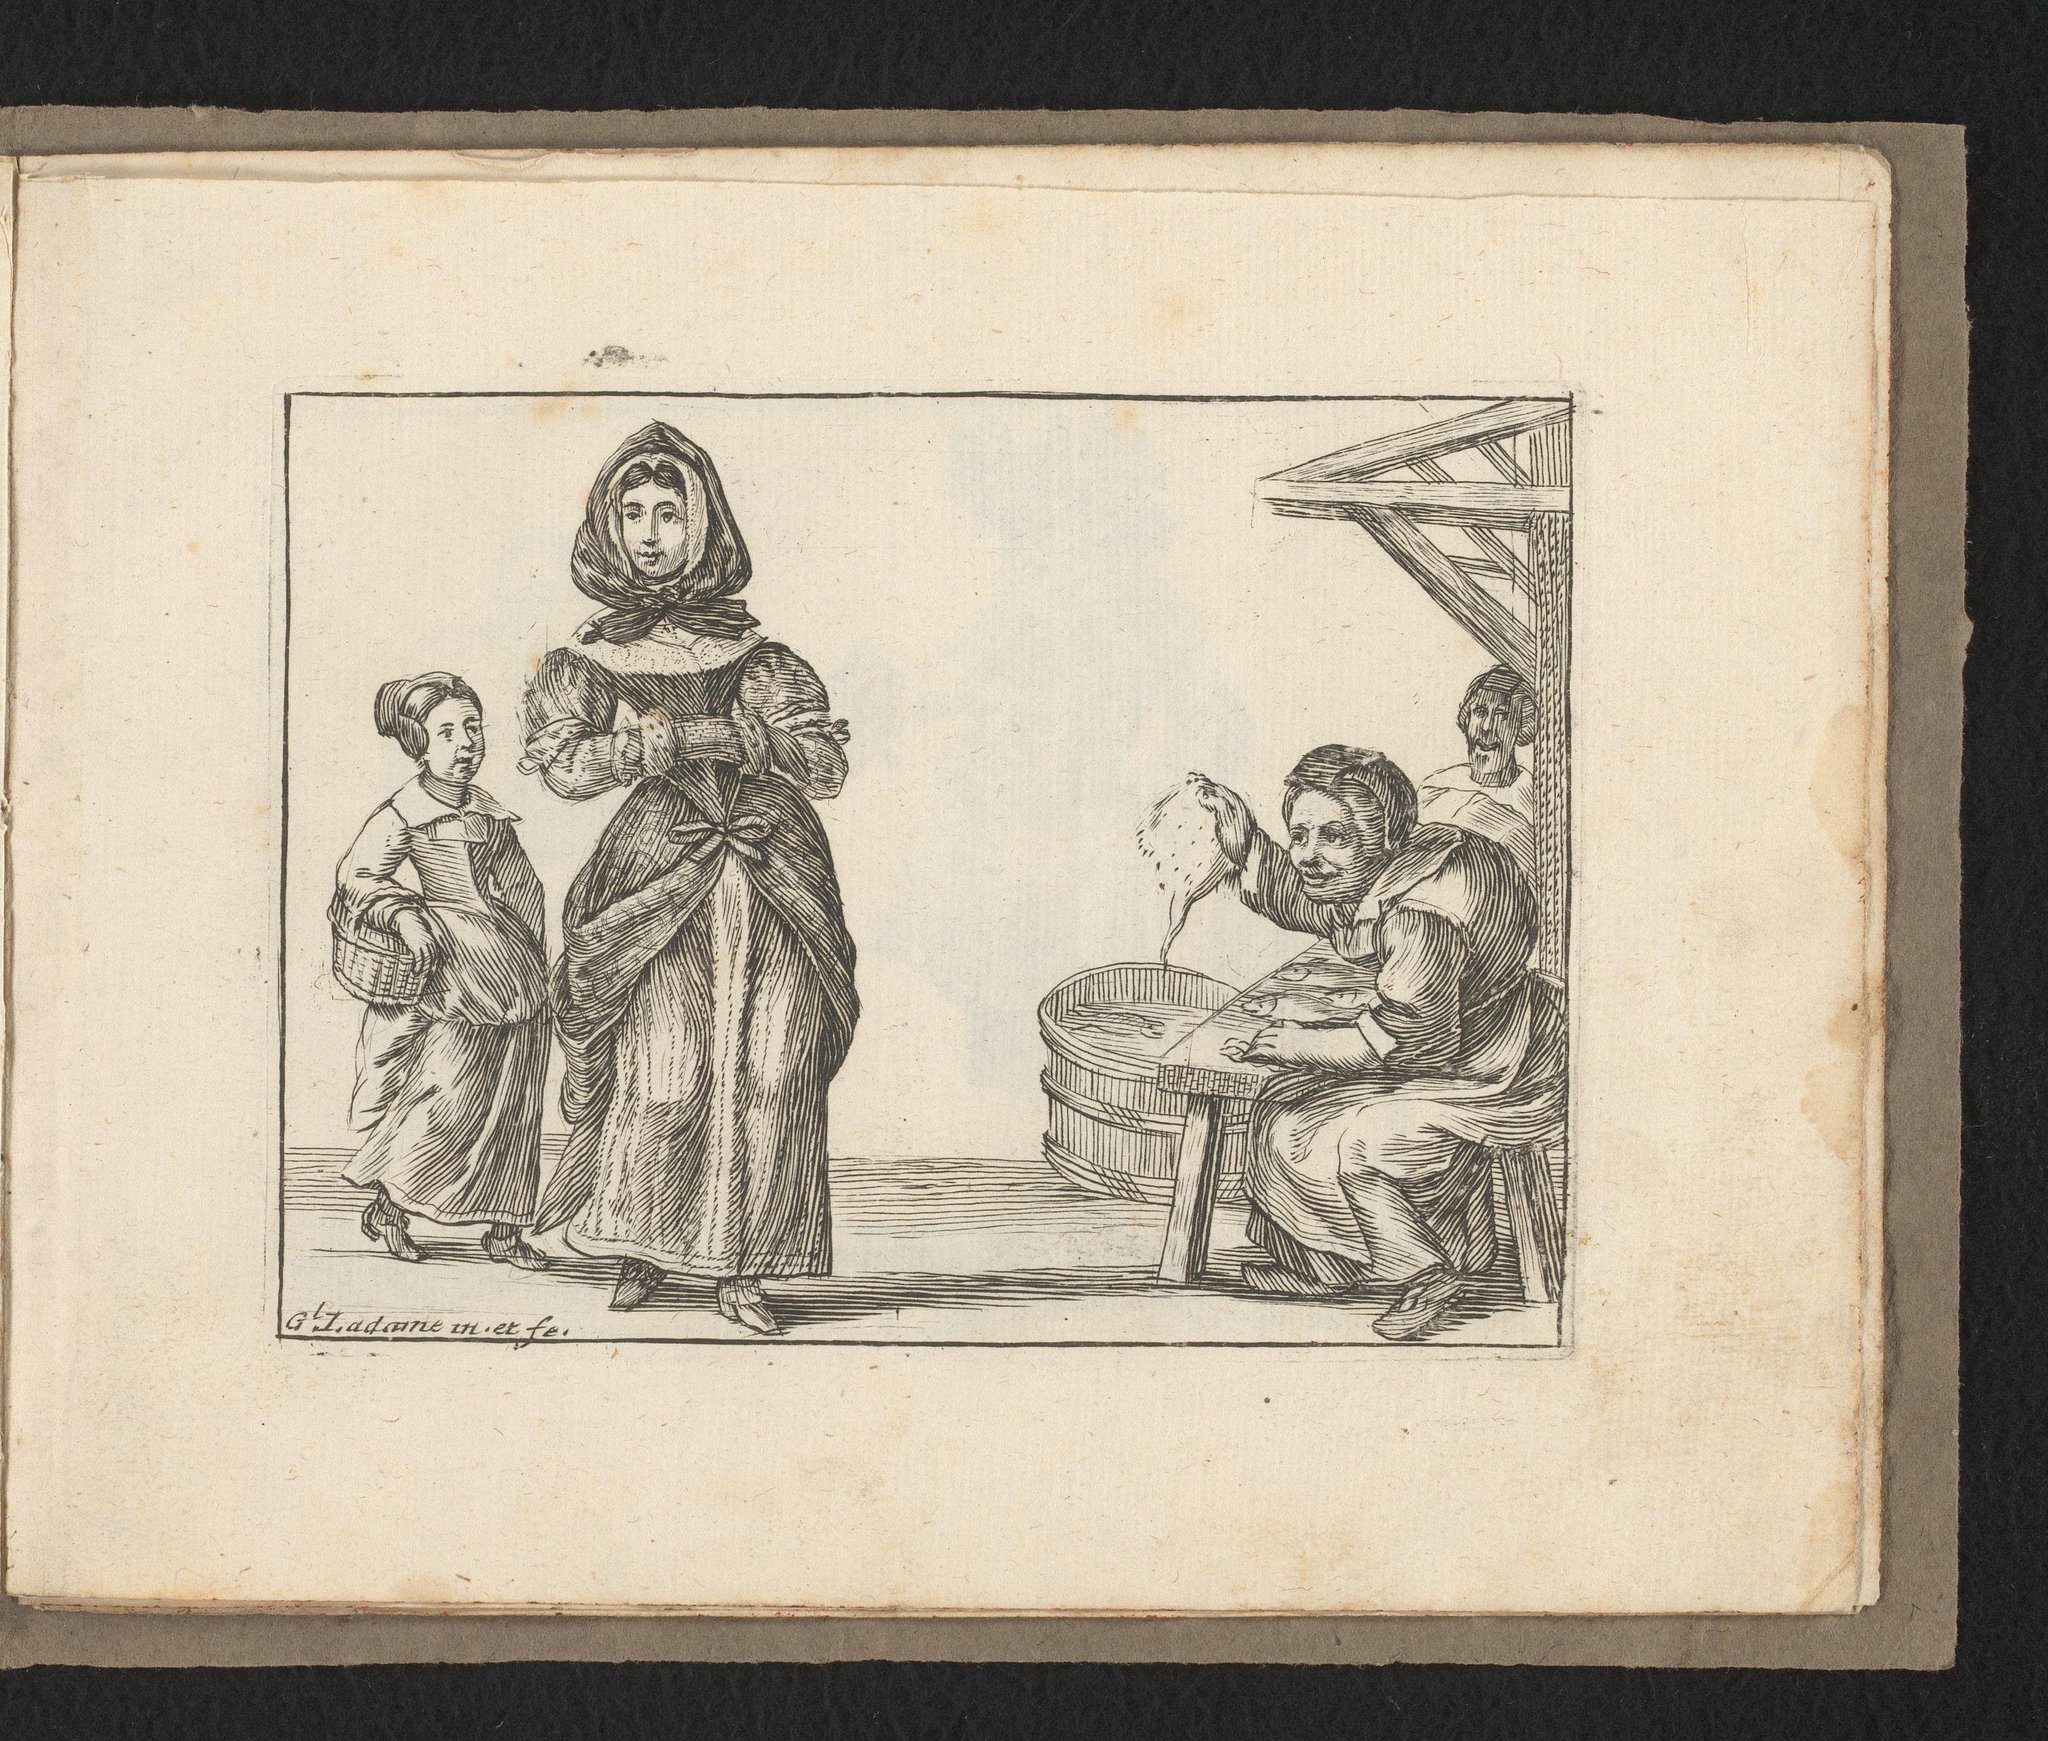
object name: print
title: Rijk geklede vrouw en een meisje bij een visverkoopster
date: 1660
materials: paper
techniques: etching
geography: paris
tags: street-trader - bb - women engaged in trade and commerce, fishes, dress, gown (+ women's clothes), house personnel, servants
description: Deze prent maakt deel uit van een album.